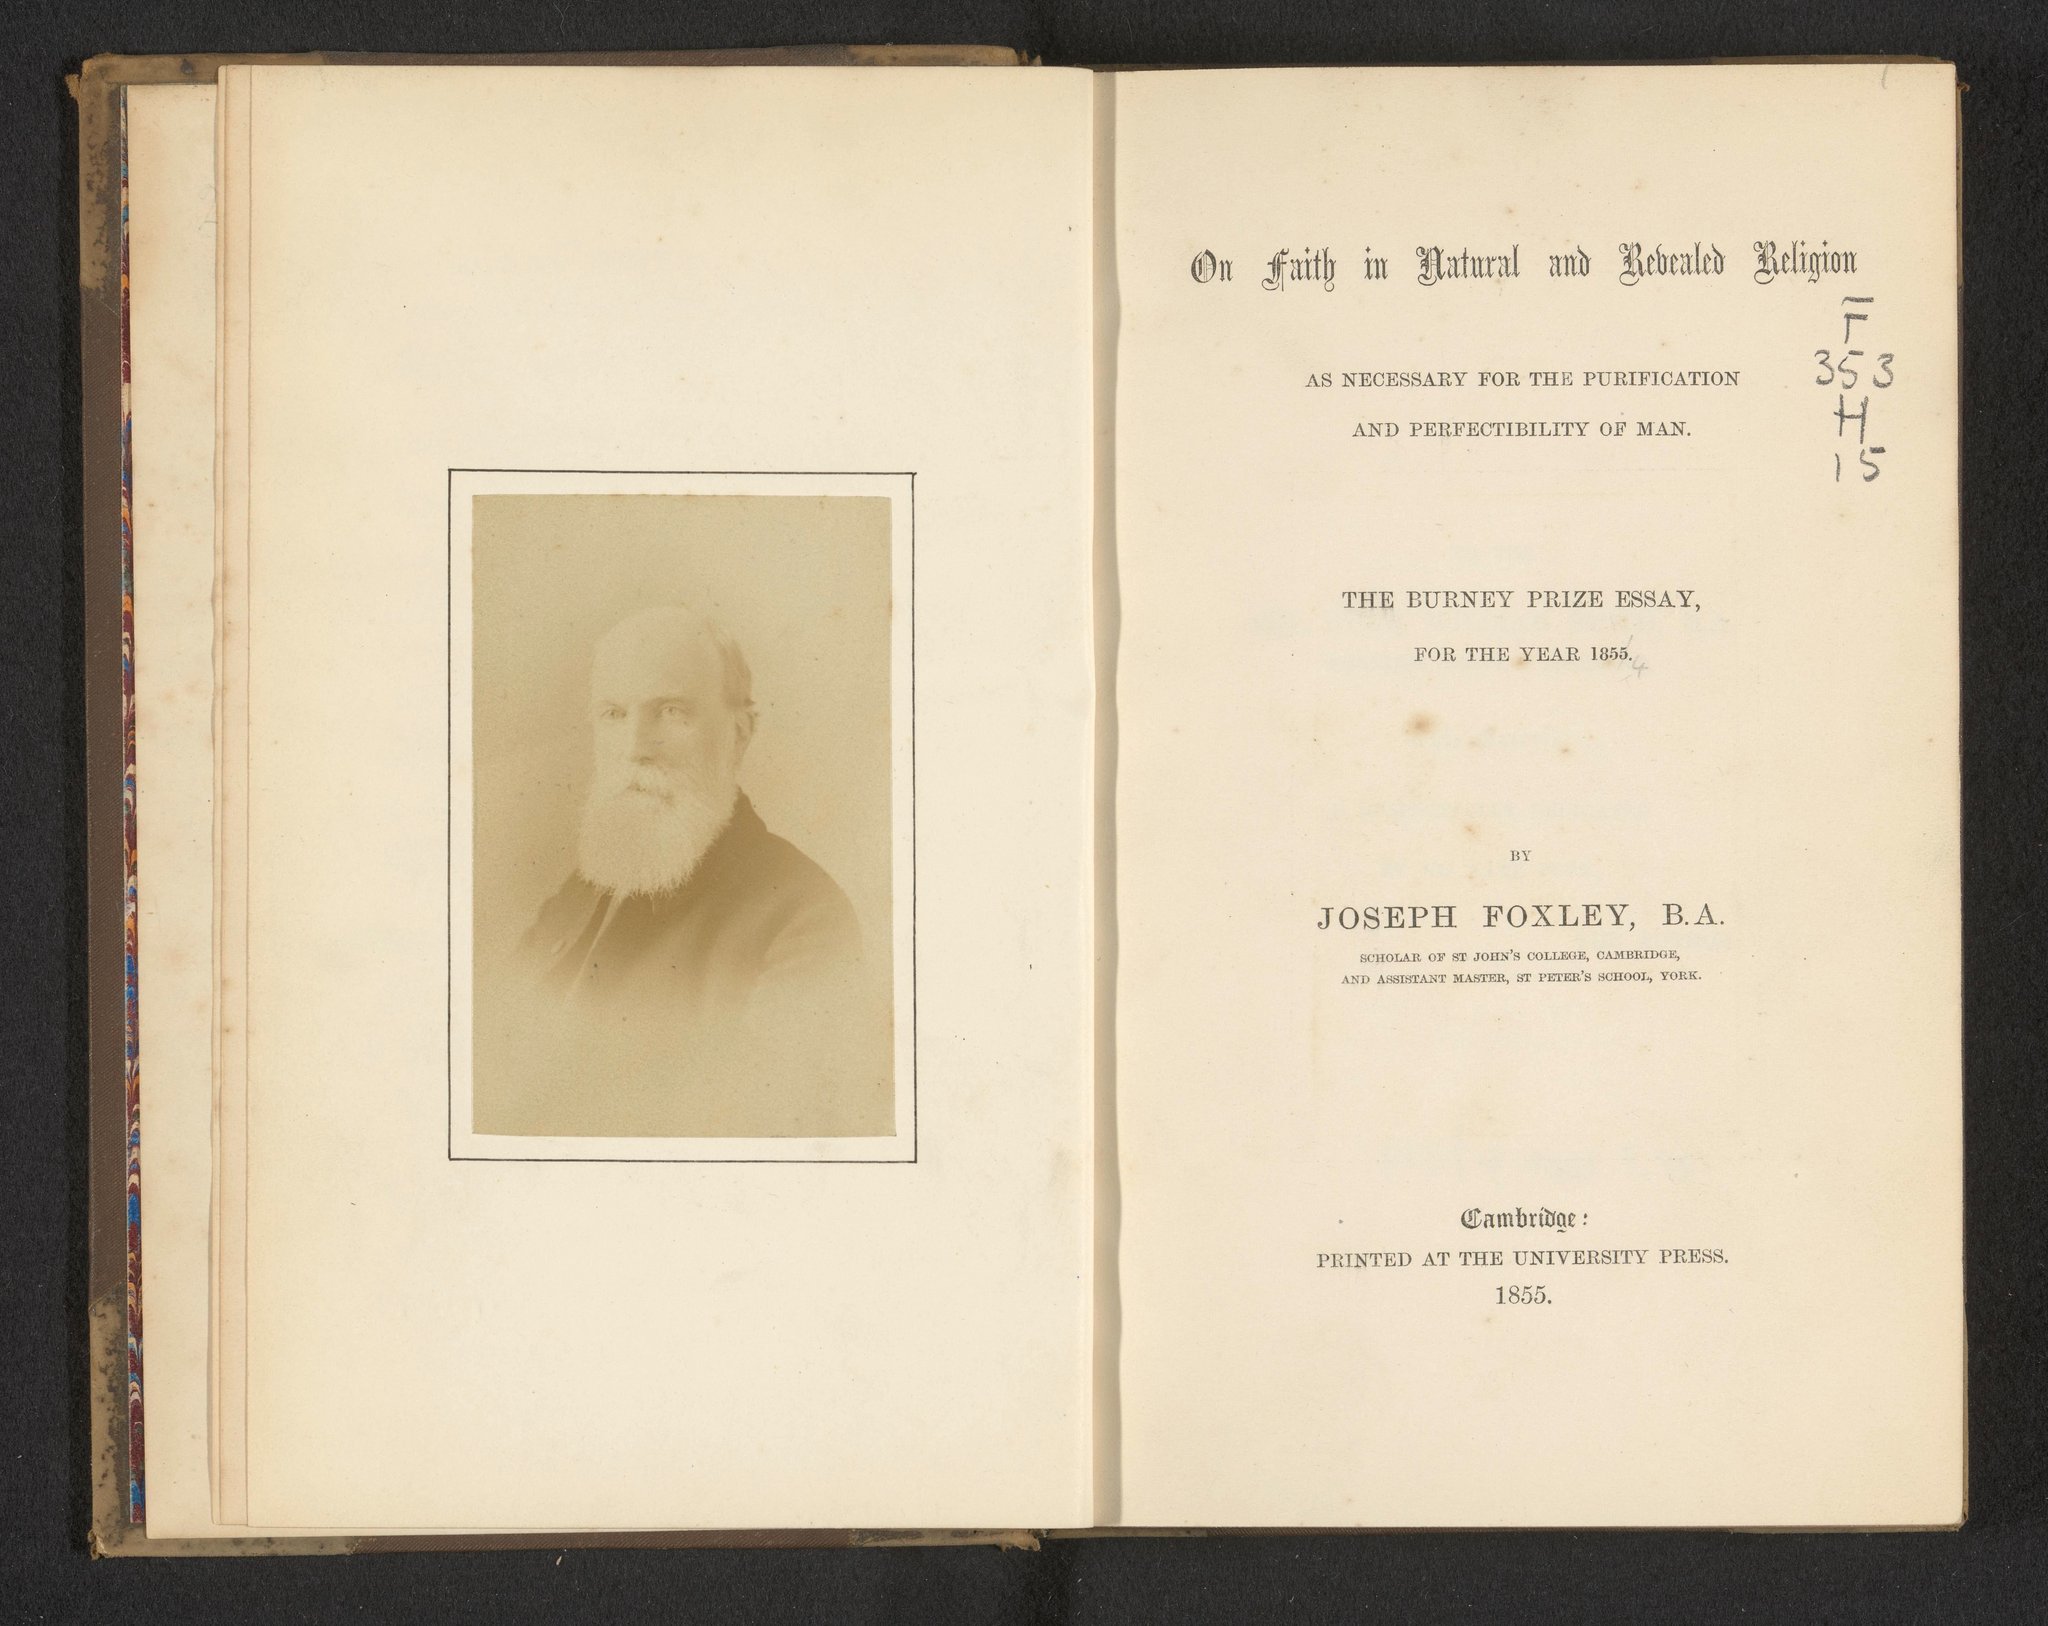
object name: book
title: On faith in natural and revealed religion, as necessary for the purification and perfectibility of man the Burney prize essay for the year 1855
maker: joseph foxley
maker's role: docent, geleerde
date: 1855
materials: leather, linen, paper, photographic support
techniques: albumen print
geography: cambridge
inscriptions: name: ‘Ex Libris Elizabeth Foxley’, name: ‘ex libris SFJ’, inscription: ‘Elizabeth Foxley from her father Easter 1891’